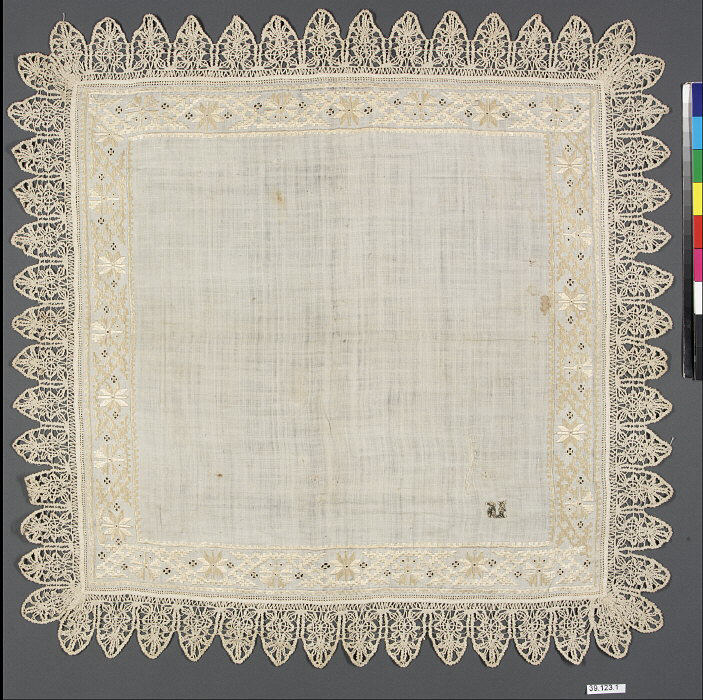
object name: handkerchief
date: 1601-1700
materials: linen, silk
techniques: lace